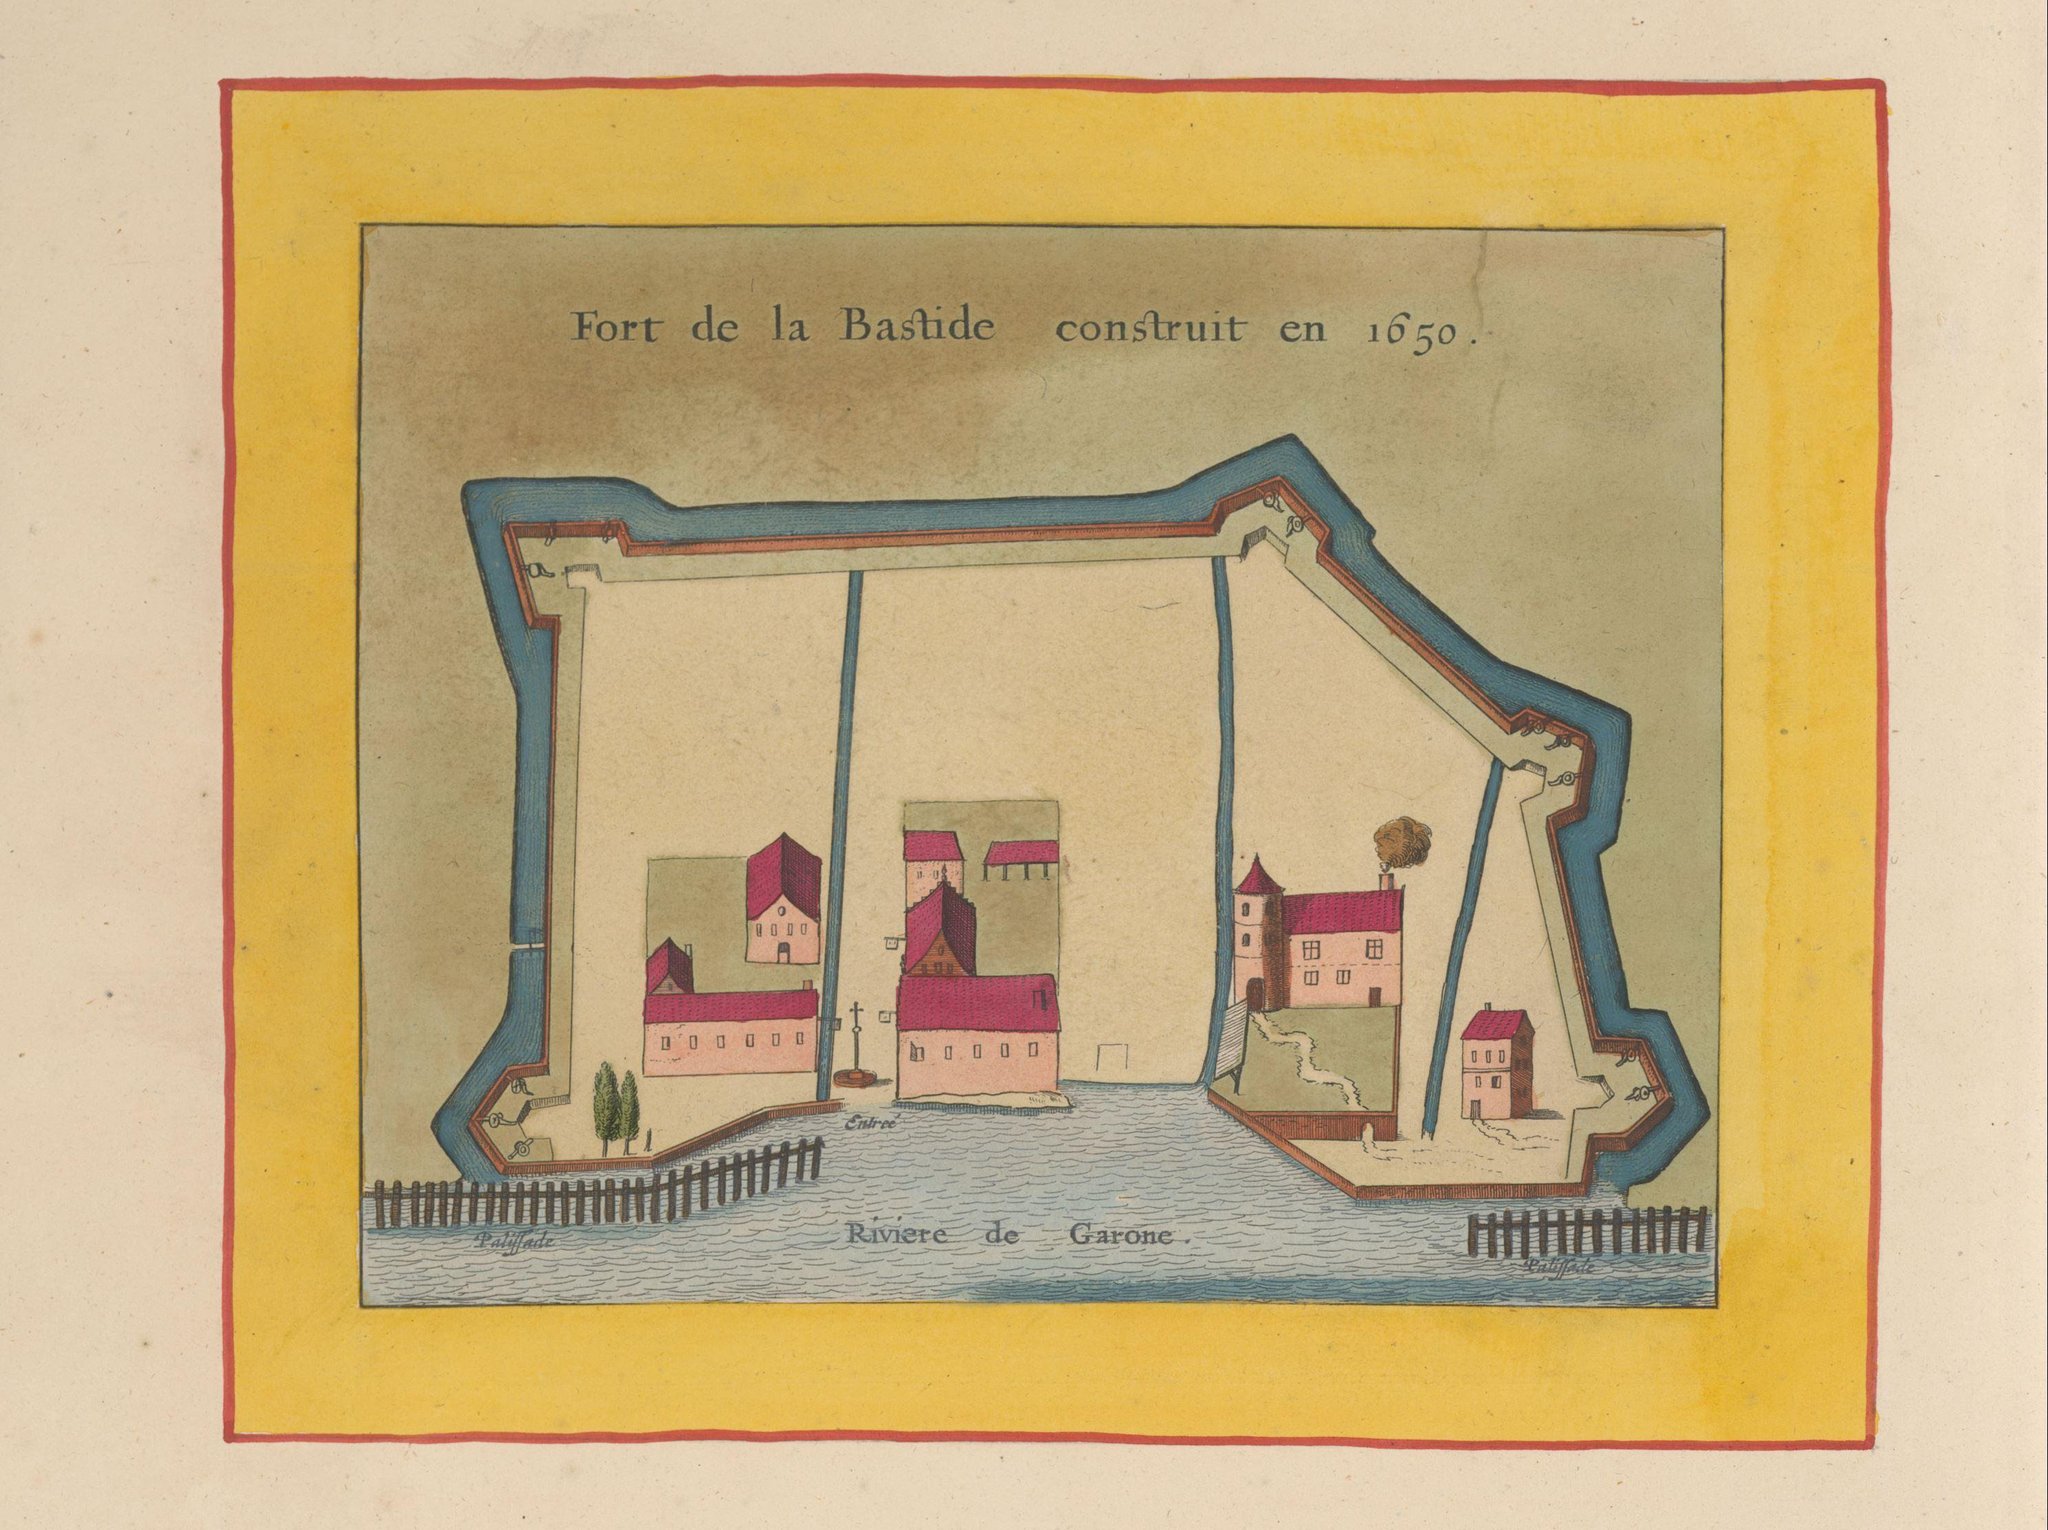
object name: area plan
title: Fort de la Bastide construit en 1650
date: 1650-1699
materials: paper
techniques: engraving, hand coloring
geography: the hague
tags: fortress, maps of cities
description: Deze prent maakt deel uit van een album.